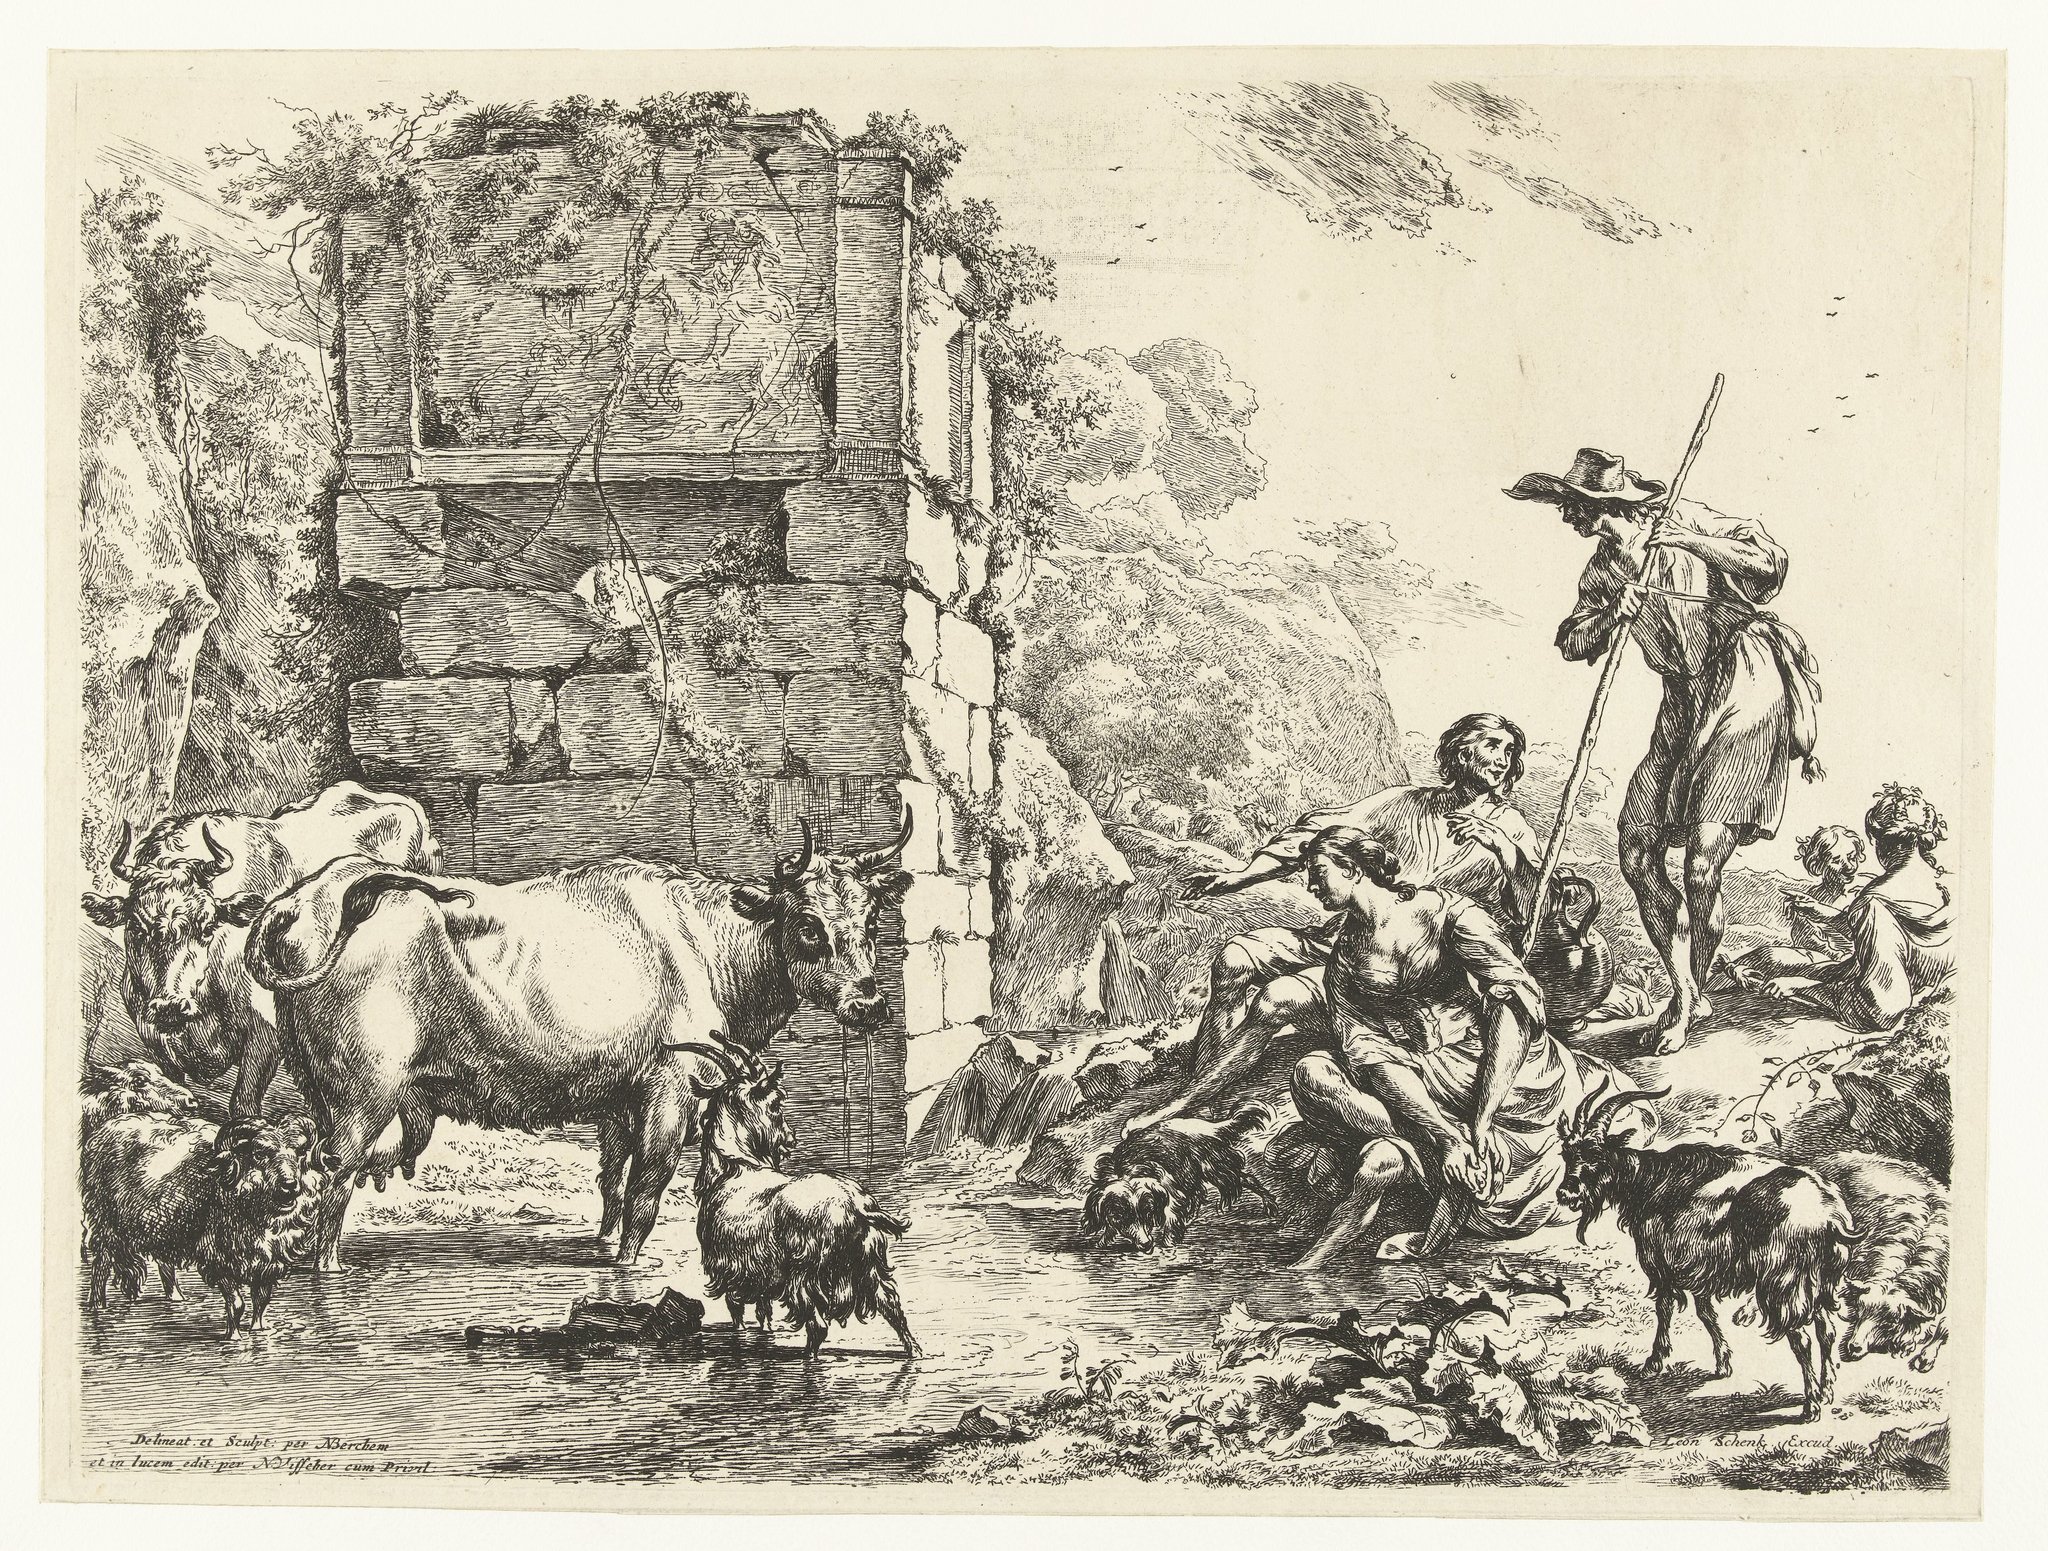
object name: print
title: Drinkende koe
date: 1680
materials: paper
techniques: etching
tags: cow, herding, herdsman, herdswoman, shepherd, shepherdess, cowherd, etc.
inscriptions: collector's mark: Lugt 240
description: Herders en herderinnen rusten met hun vee bij een beek in een rotslandschap. Twee koeien, een geit en twee schapen staan in ondiep water voor een vervallen monument met een reliëf. De titel dankt de prent aan de koe met de snuit waar het water van afdruipt.